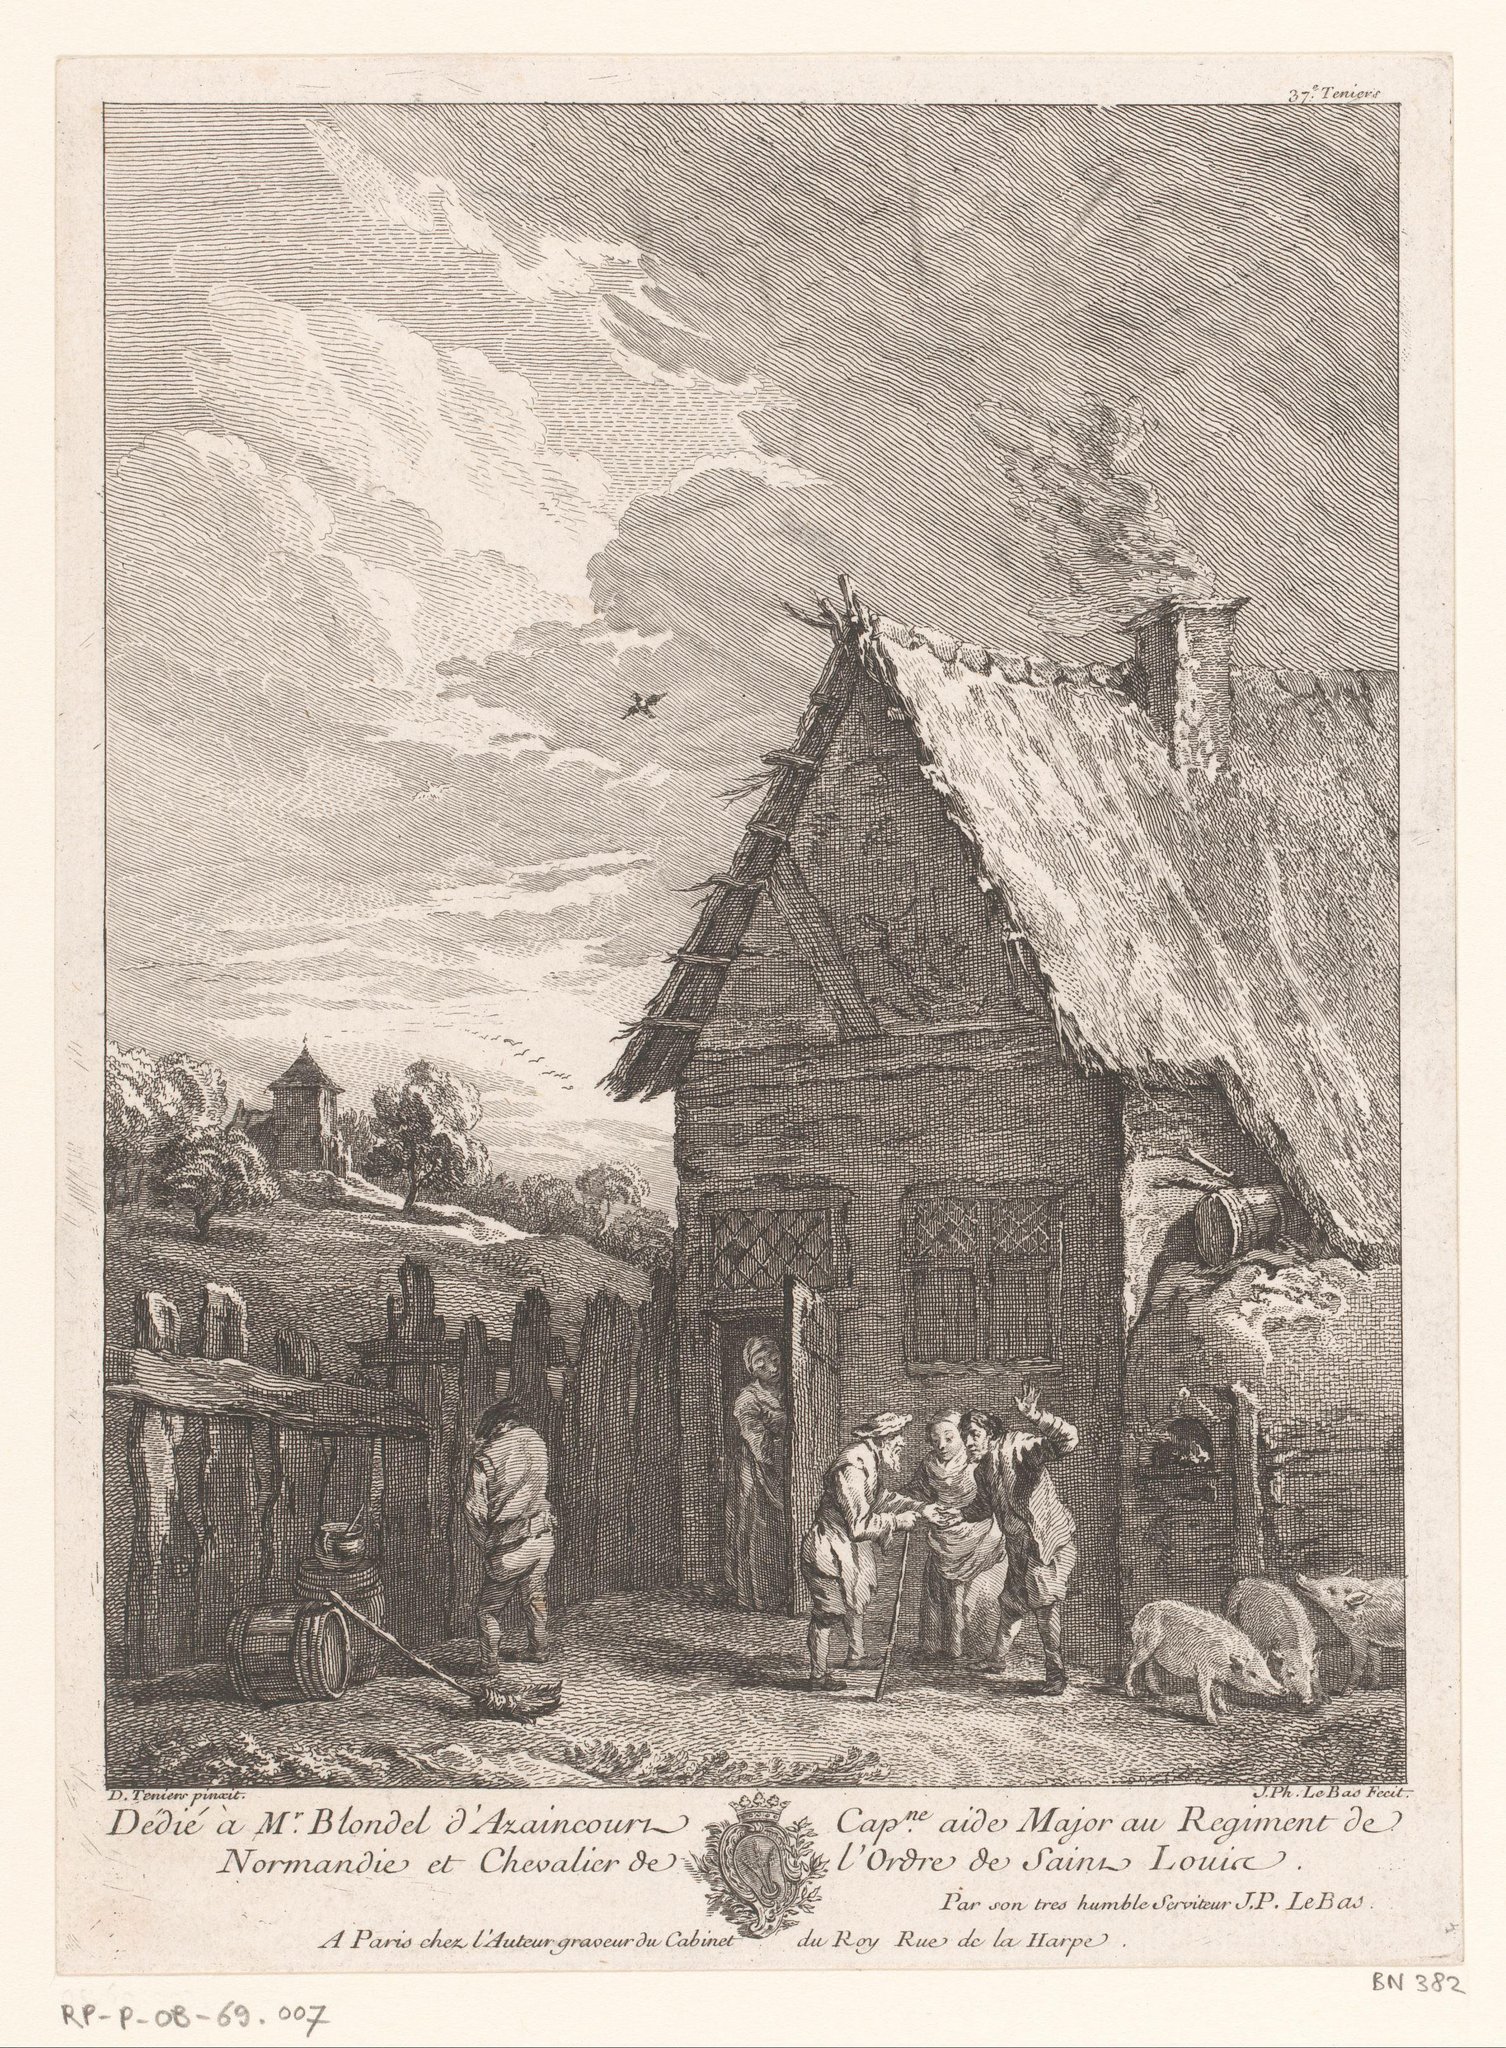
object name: print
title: Verschillende figuren voor een boerenhuis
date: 1717-1783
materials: paper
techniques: etching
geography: france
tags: courtyard, farm (building)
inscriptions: collector's mark: Lugt 240